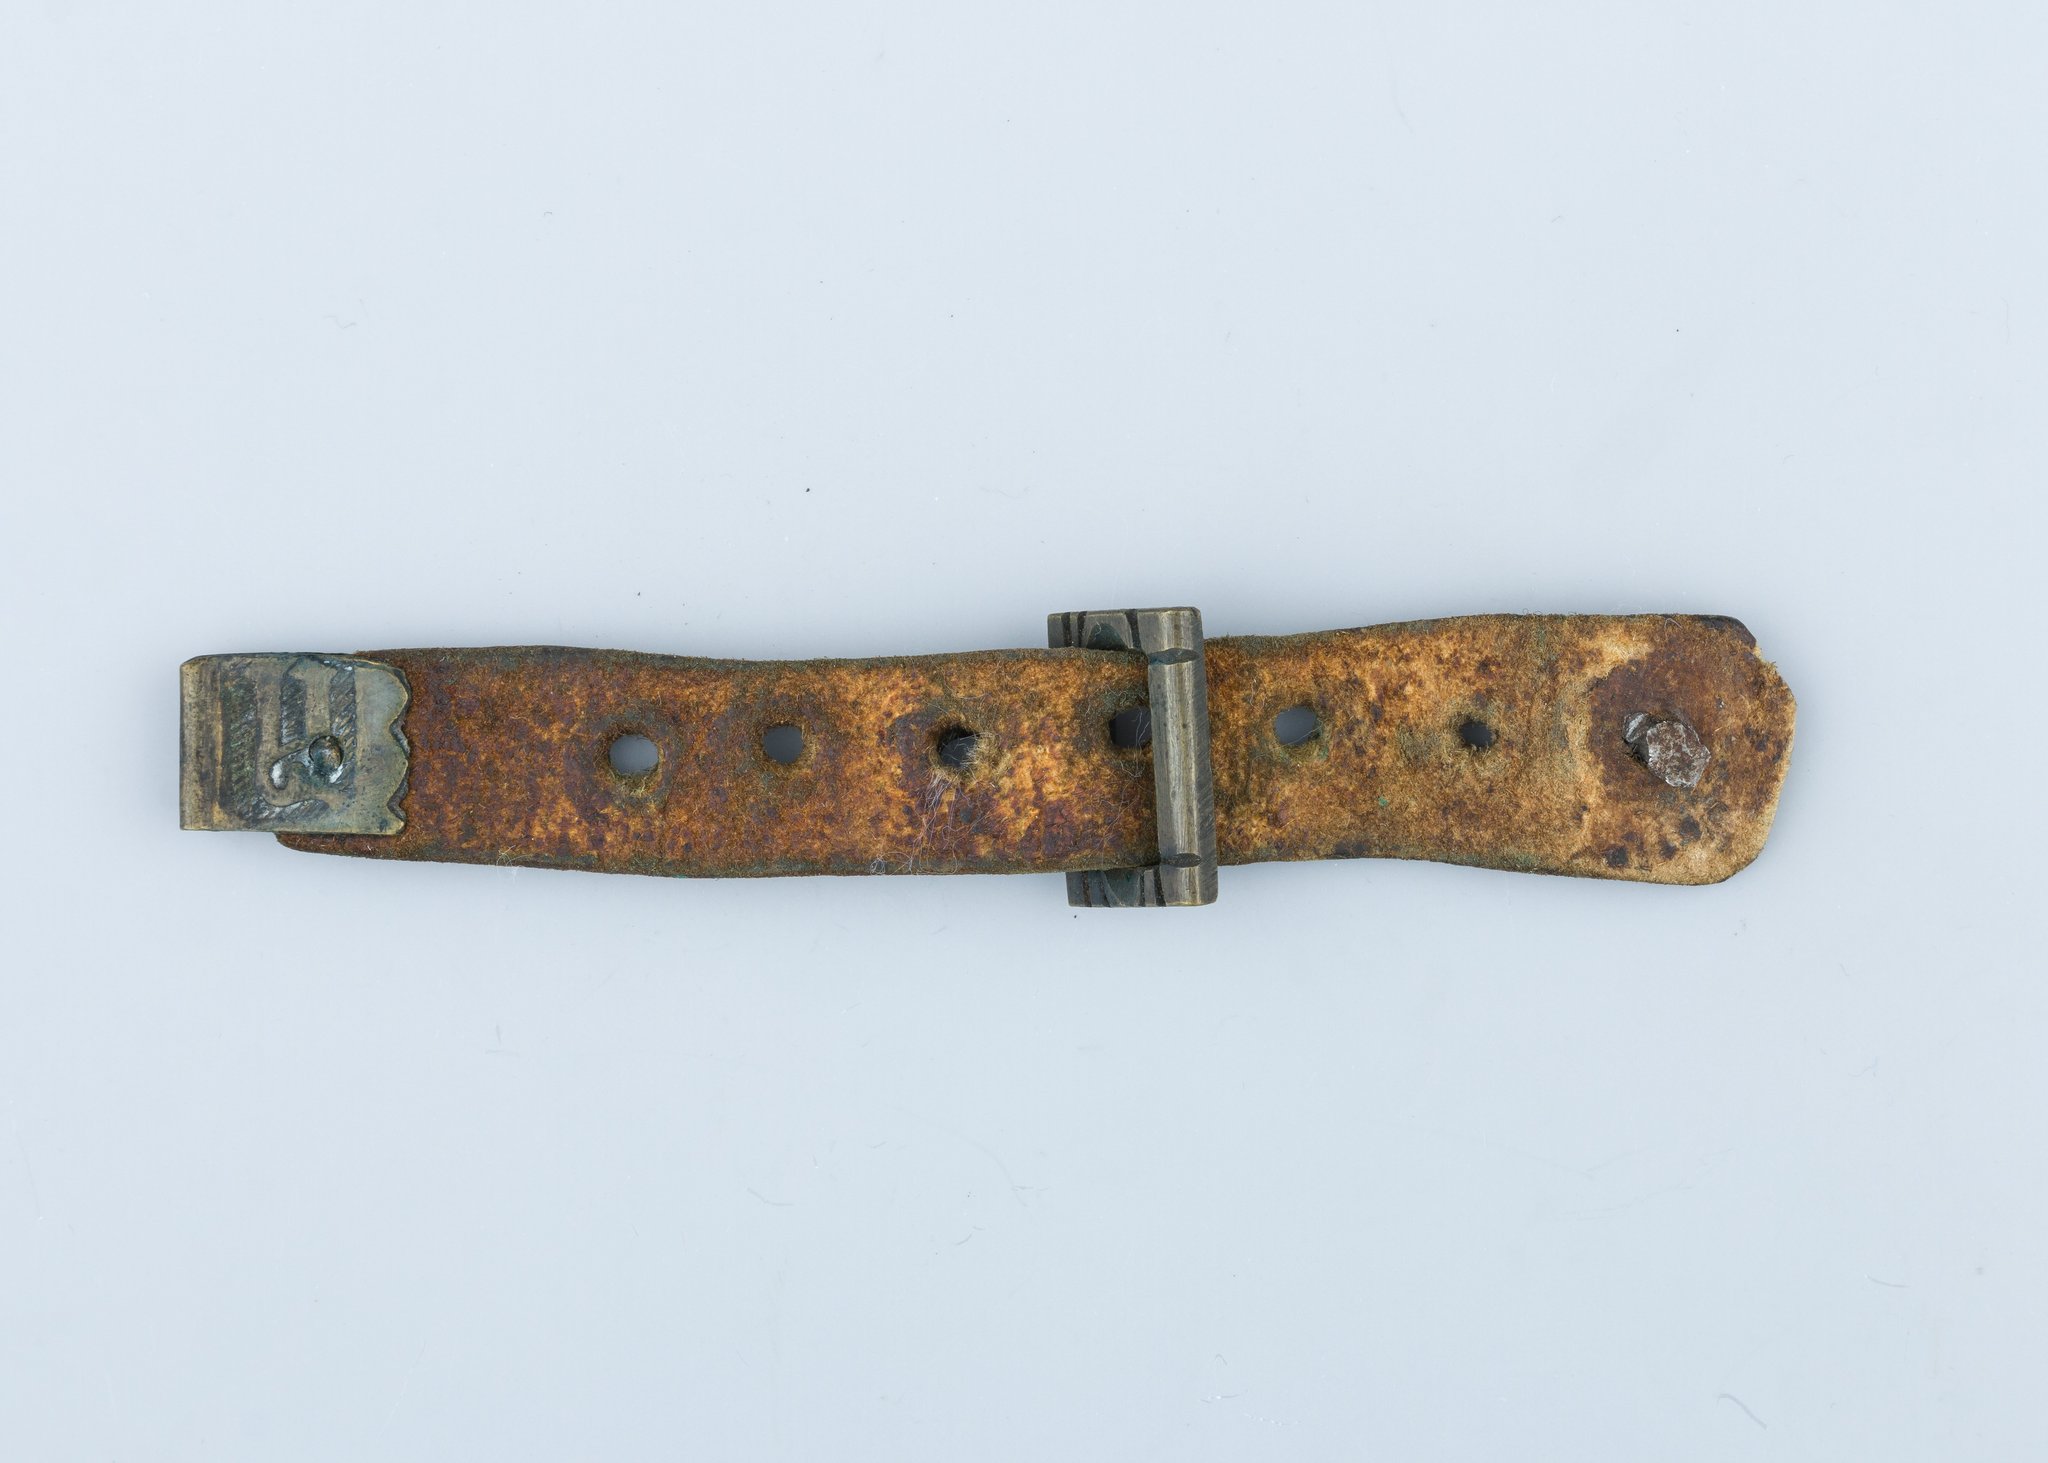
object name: buckle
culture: german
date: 1500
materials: brass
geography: germany